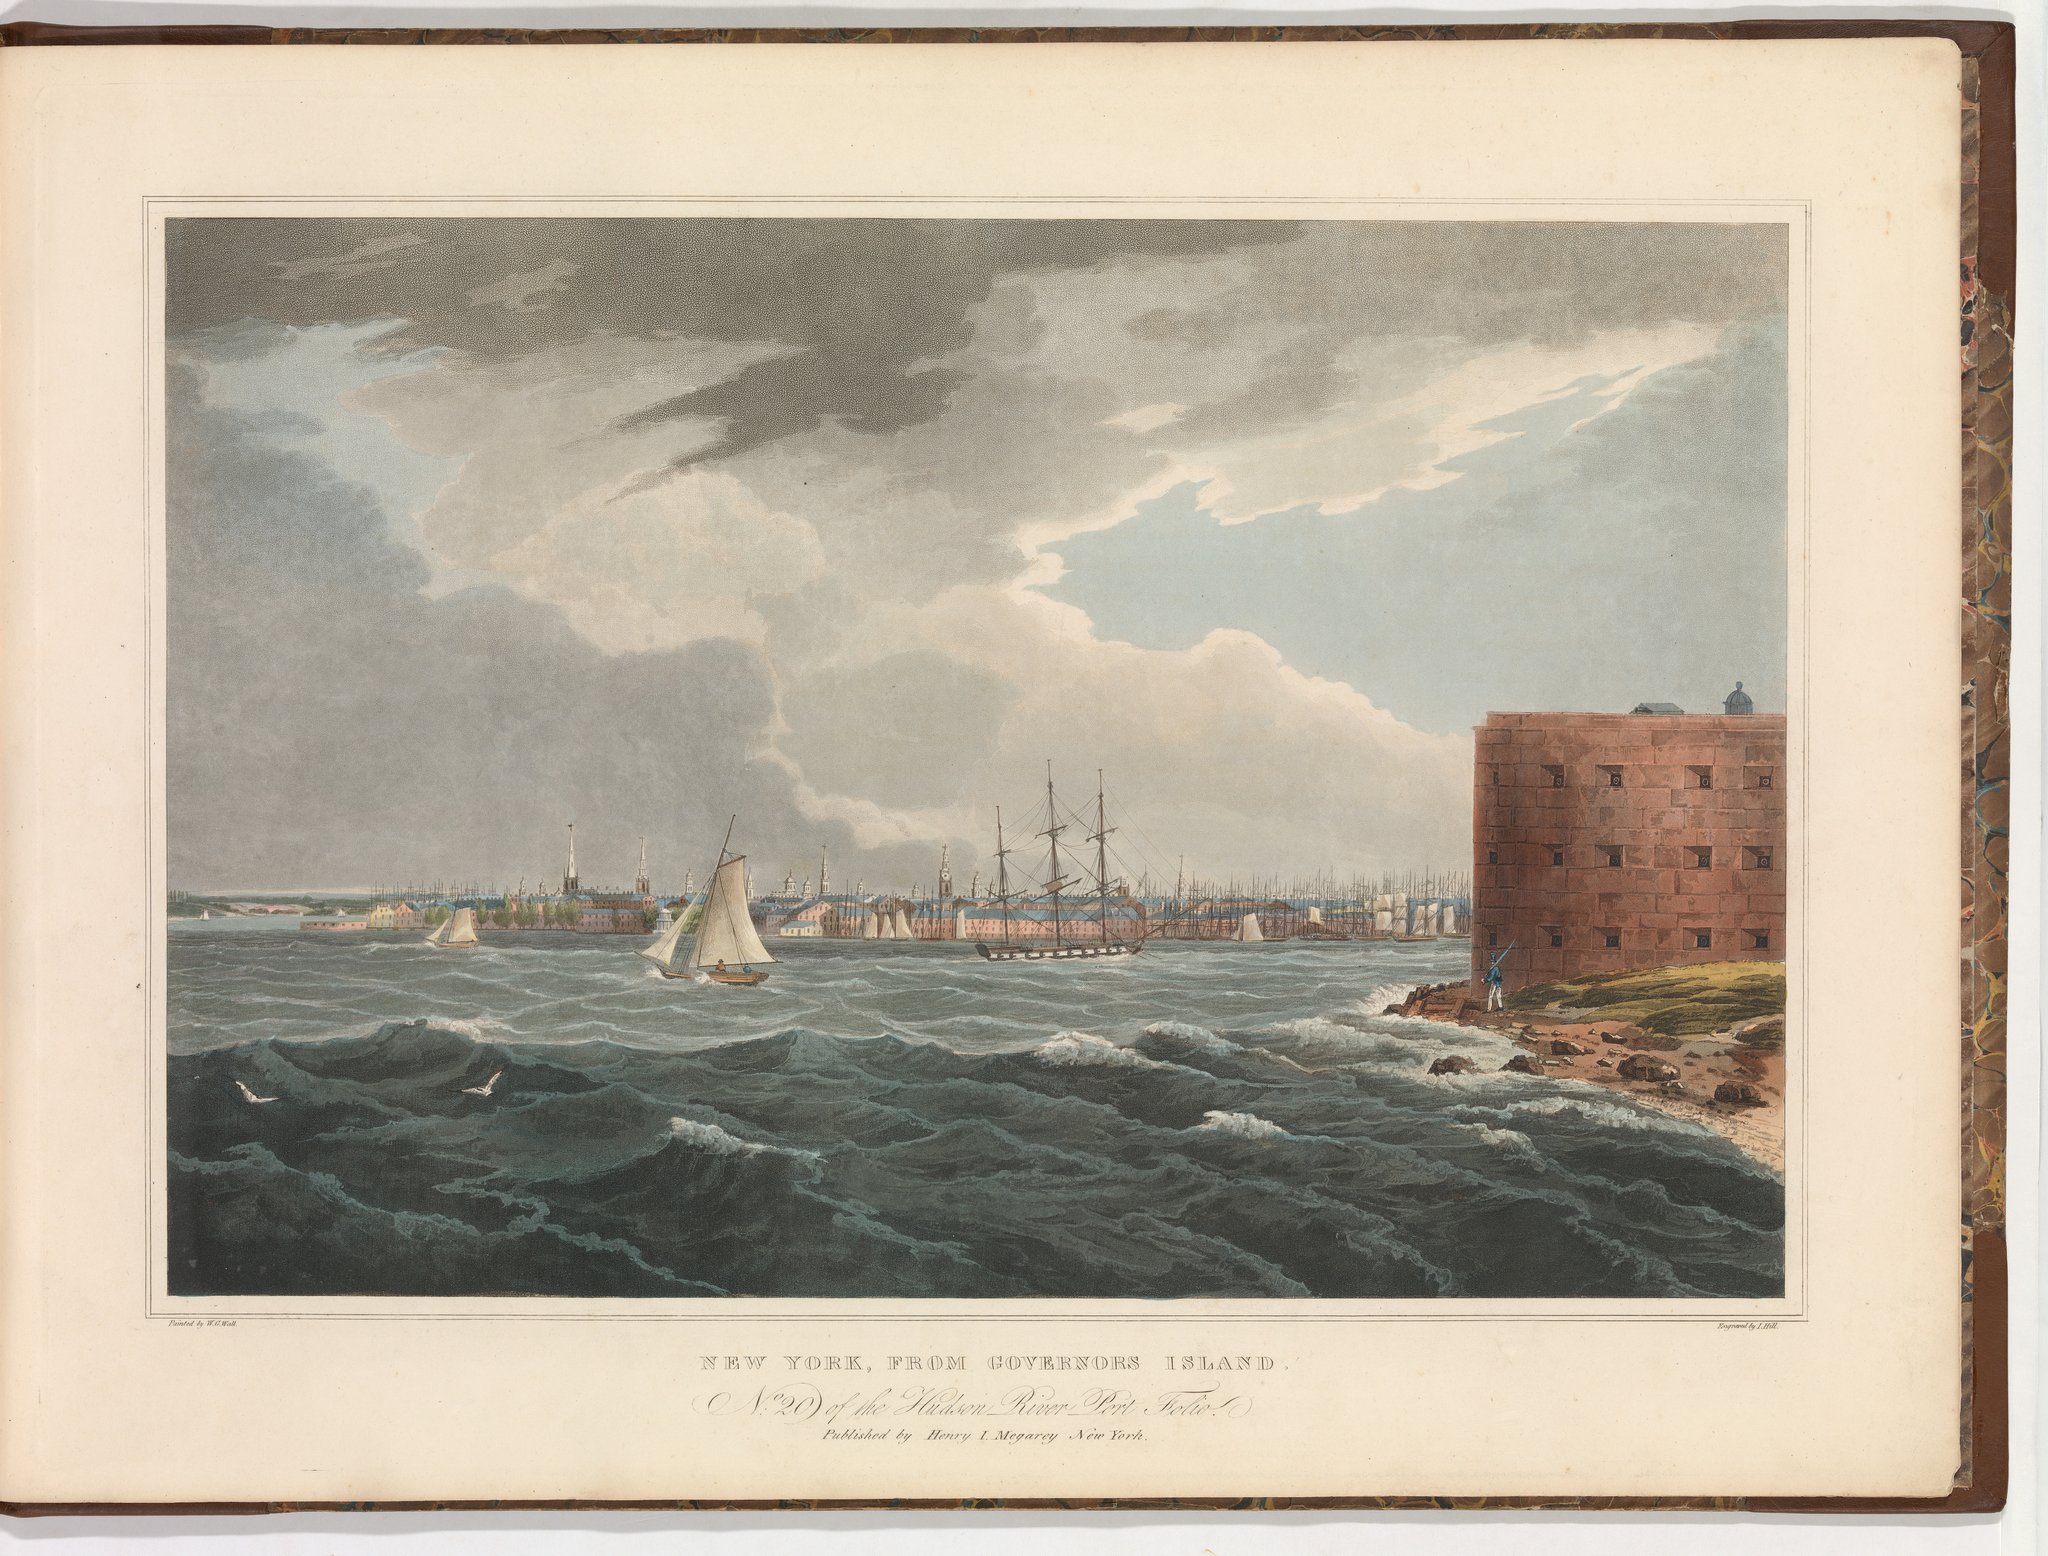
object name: print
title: New York from Governor's Island (No. 20 of The Hudson River Portfolio)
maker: john hill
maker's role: etcher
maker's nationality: american, born england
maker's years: 1770-1850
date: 1823-1824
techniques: aquatint, hand coloring, printing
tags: rivers,boats,new york city